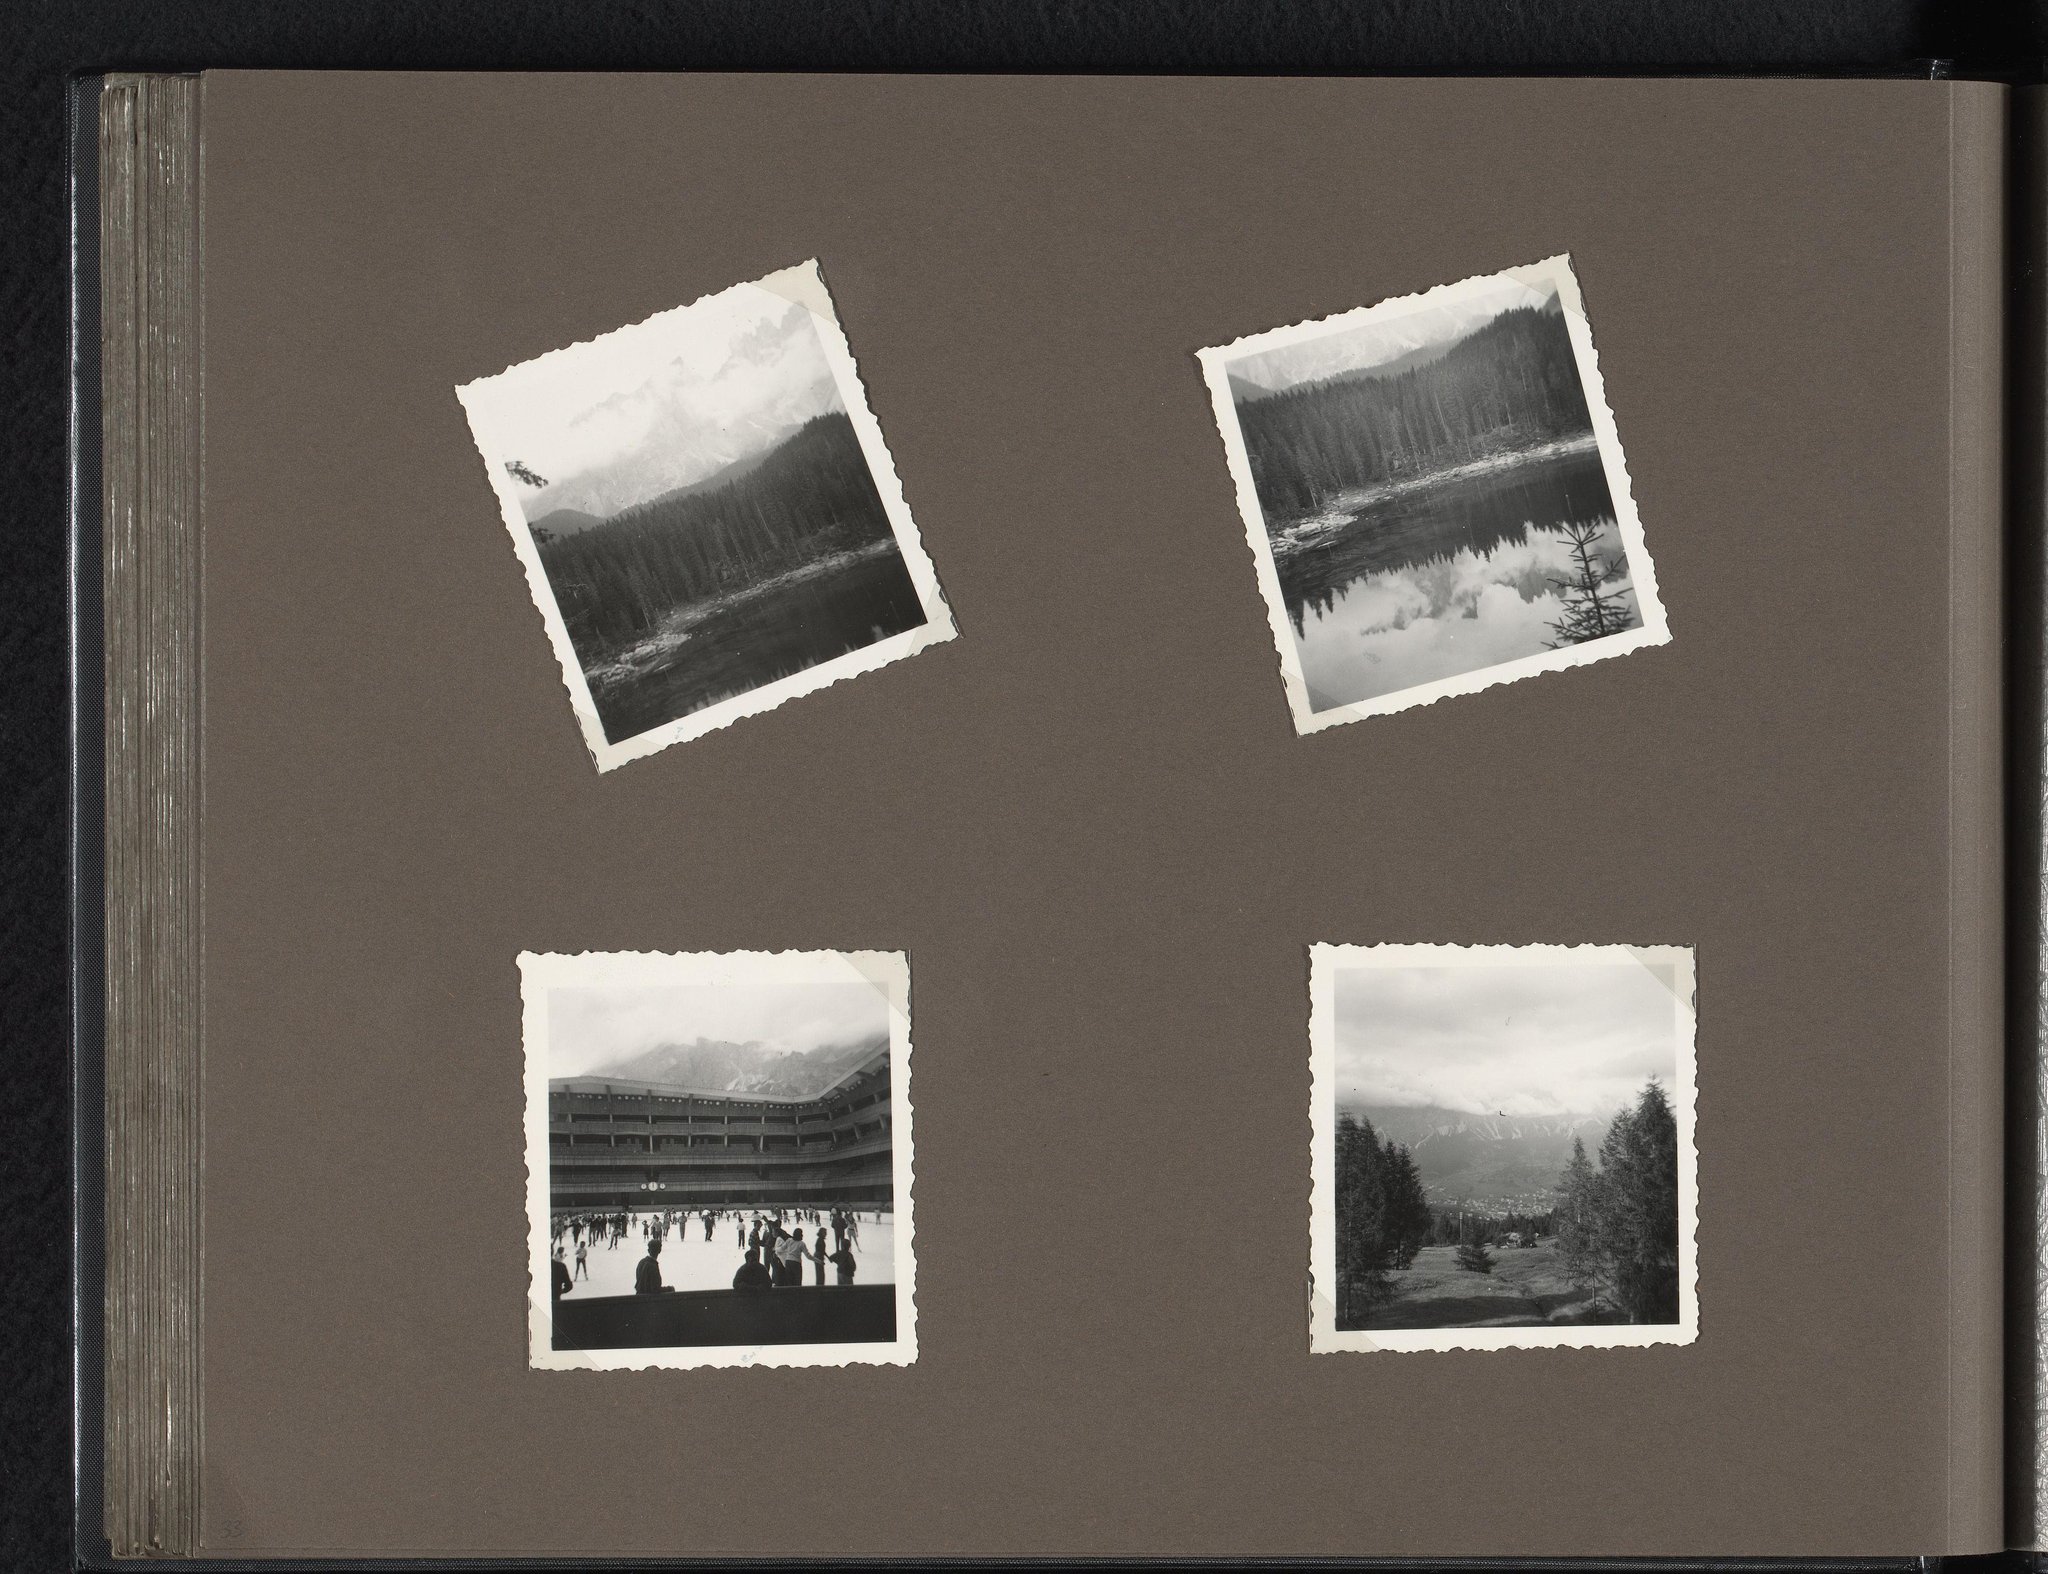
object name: photograph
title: Natuurgezichten en schaatsbaan, mogelijk in Duitsland of de Verenigde Staten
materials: paper, cardboard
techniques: gelatin silver print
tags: lake, forest, wood, skates (winter sports)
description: Blad bevat vier foto's, zonder personen gerelateerd aan de familie Wachenheimer. Deze foto's maken deel uit van een album.